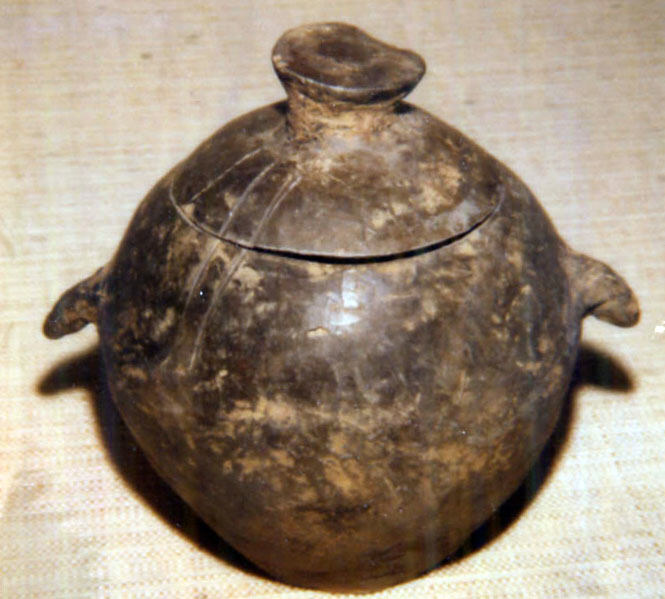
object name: covered jar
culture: chinese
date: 2500 BCE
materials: earthenware